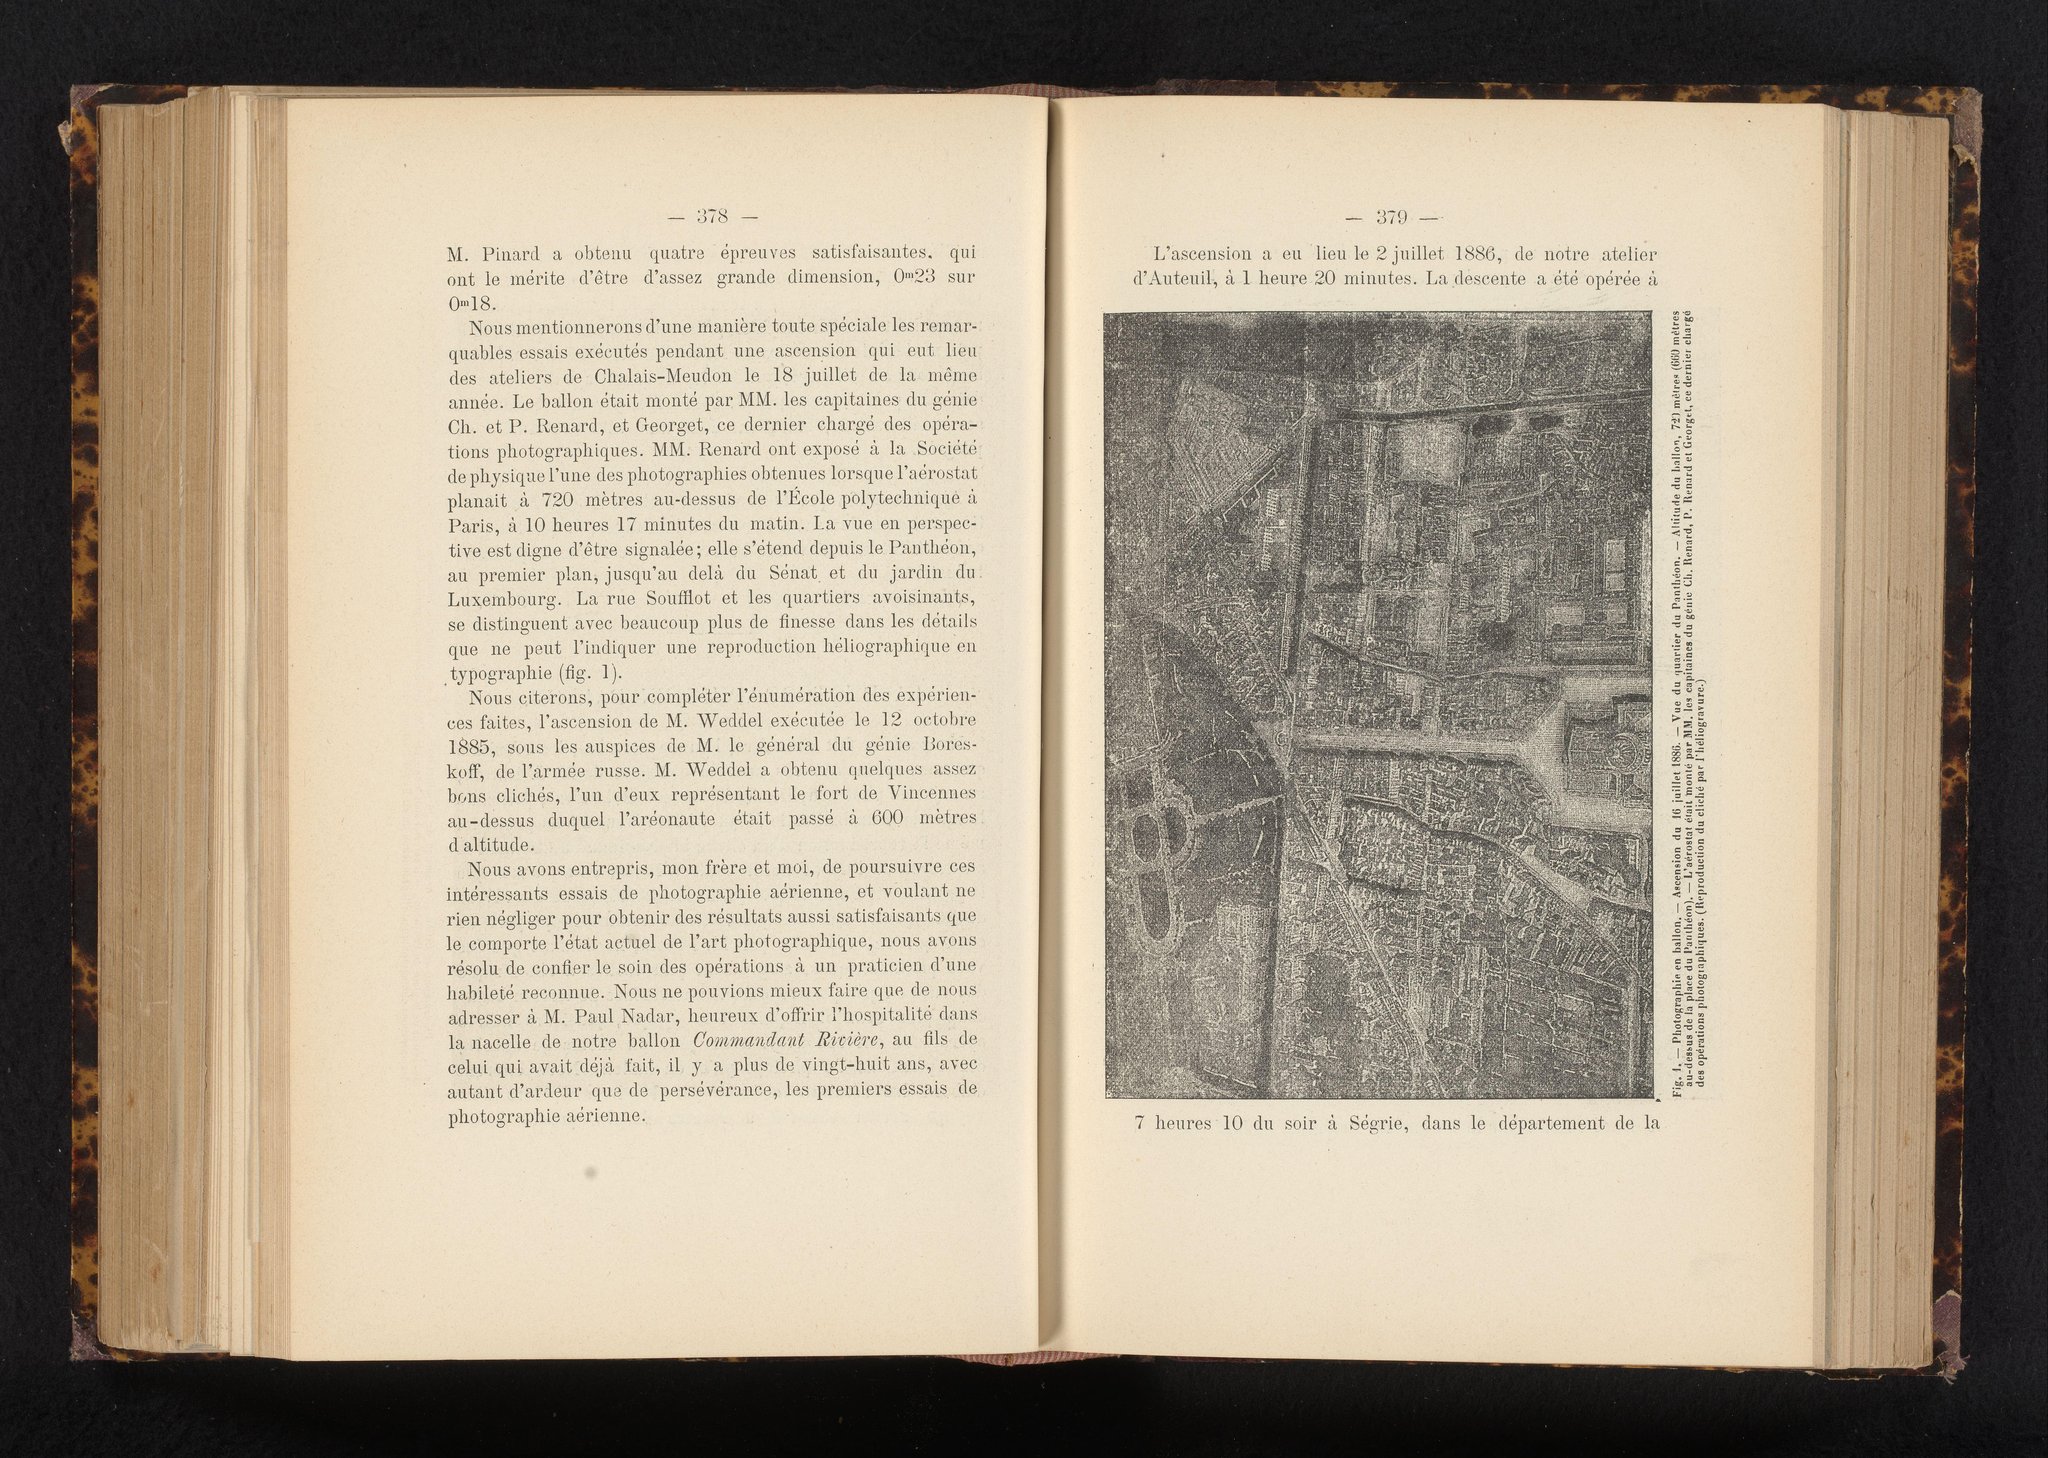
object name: photomechanical print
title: Luchtfoto van de buurt rond het Panthéon, Parijs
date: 1886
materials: paper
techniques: photomechanical printing process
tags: city-view in general; 'veduta'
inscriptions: inscription: ‘Fig. 1.- (...) Altitude du ballon (...) par l'héliogravure.)’